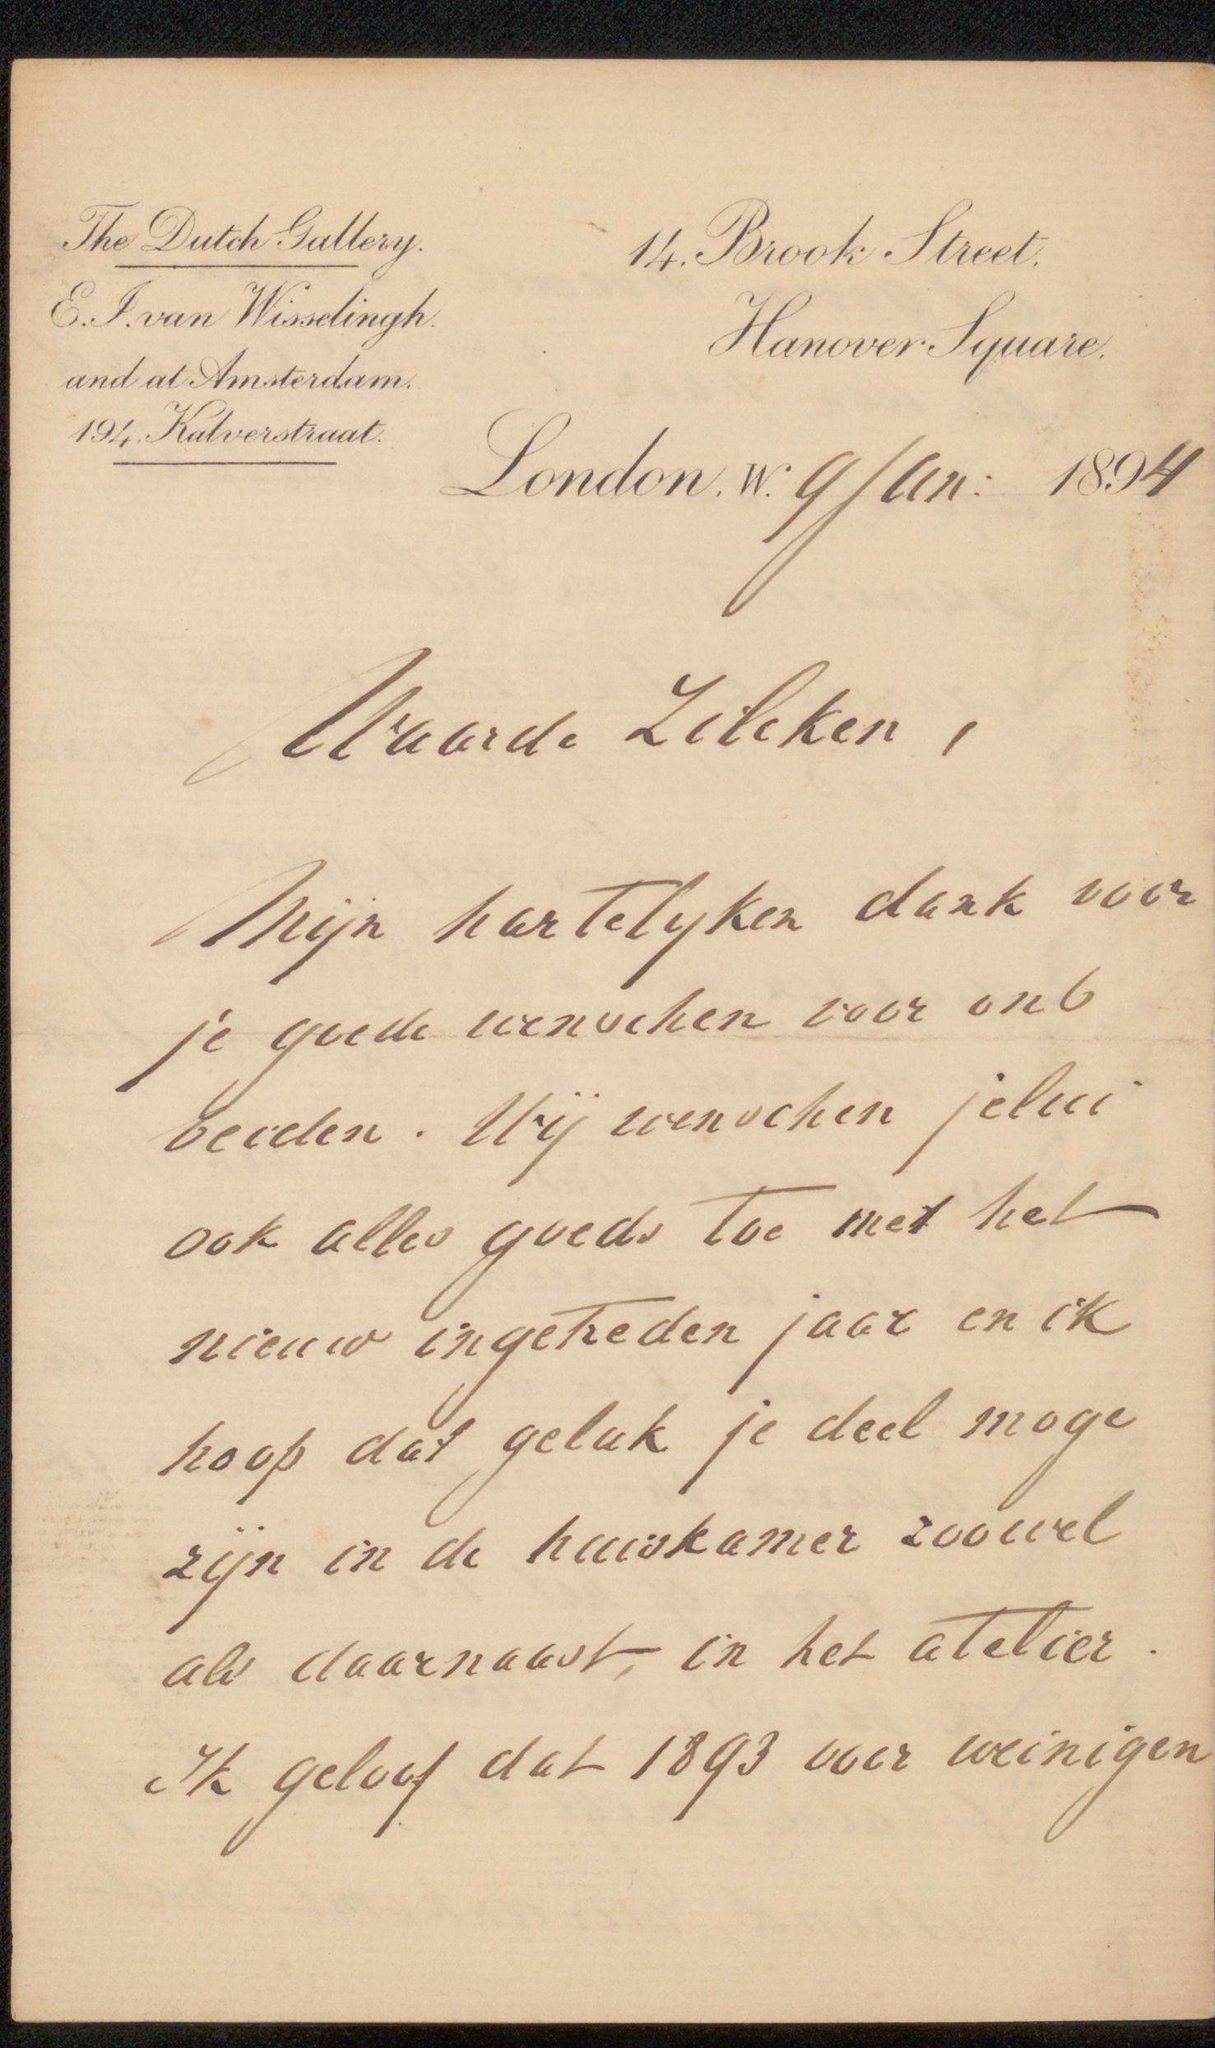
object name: letter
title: Brief aan Philip Zilcken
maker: elbert jan van wisselingh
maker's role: kunsthandelaar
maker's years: 1848-1912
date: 1894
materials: ink, paper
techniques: pen, printing, writing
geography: london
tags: joseph bouwens, klaas groesbeek, j. craibe angus, the hague, painter, philip zilcken, the graphic arts, historical persons (portraits and scenes from the life), rotterdam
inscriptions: watermark, collector's mark: ‘RPK’